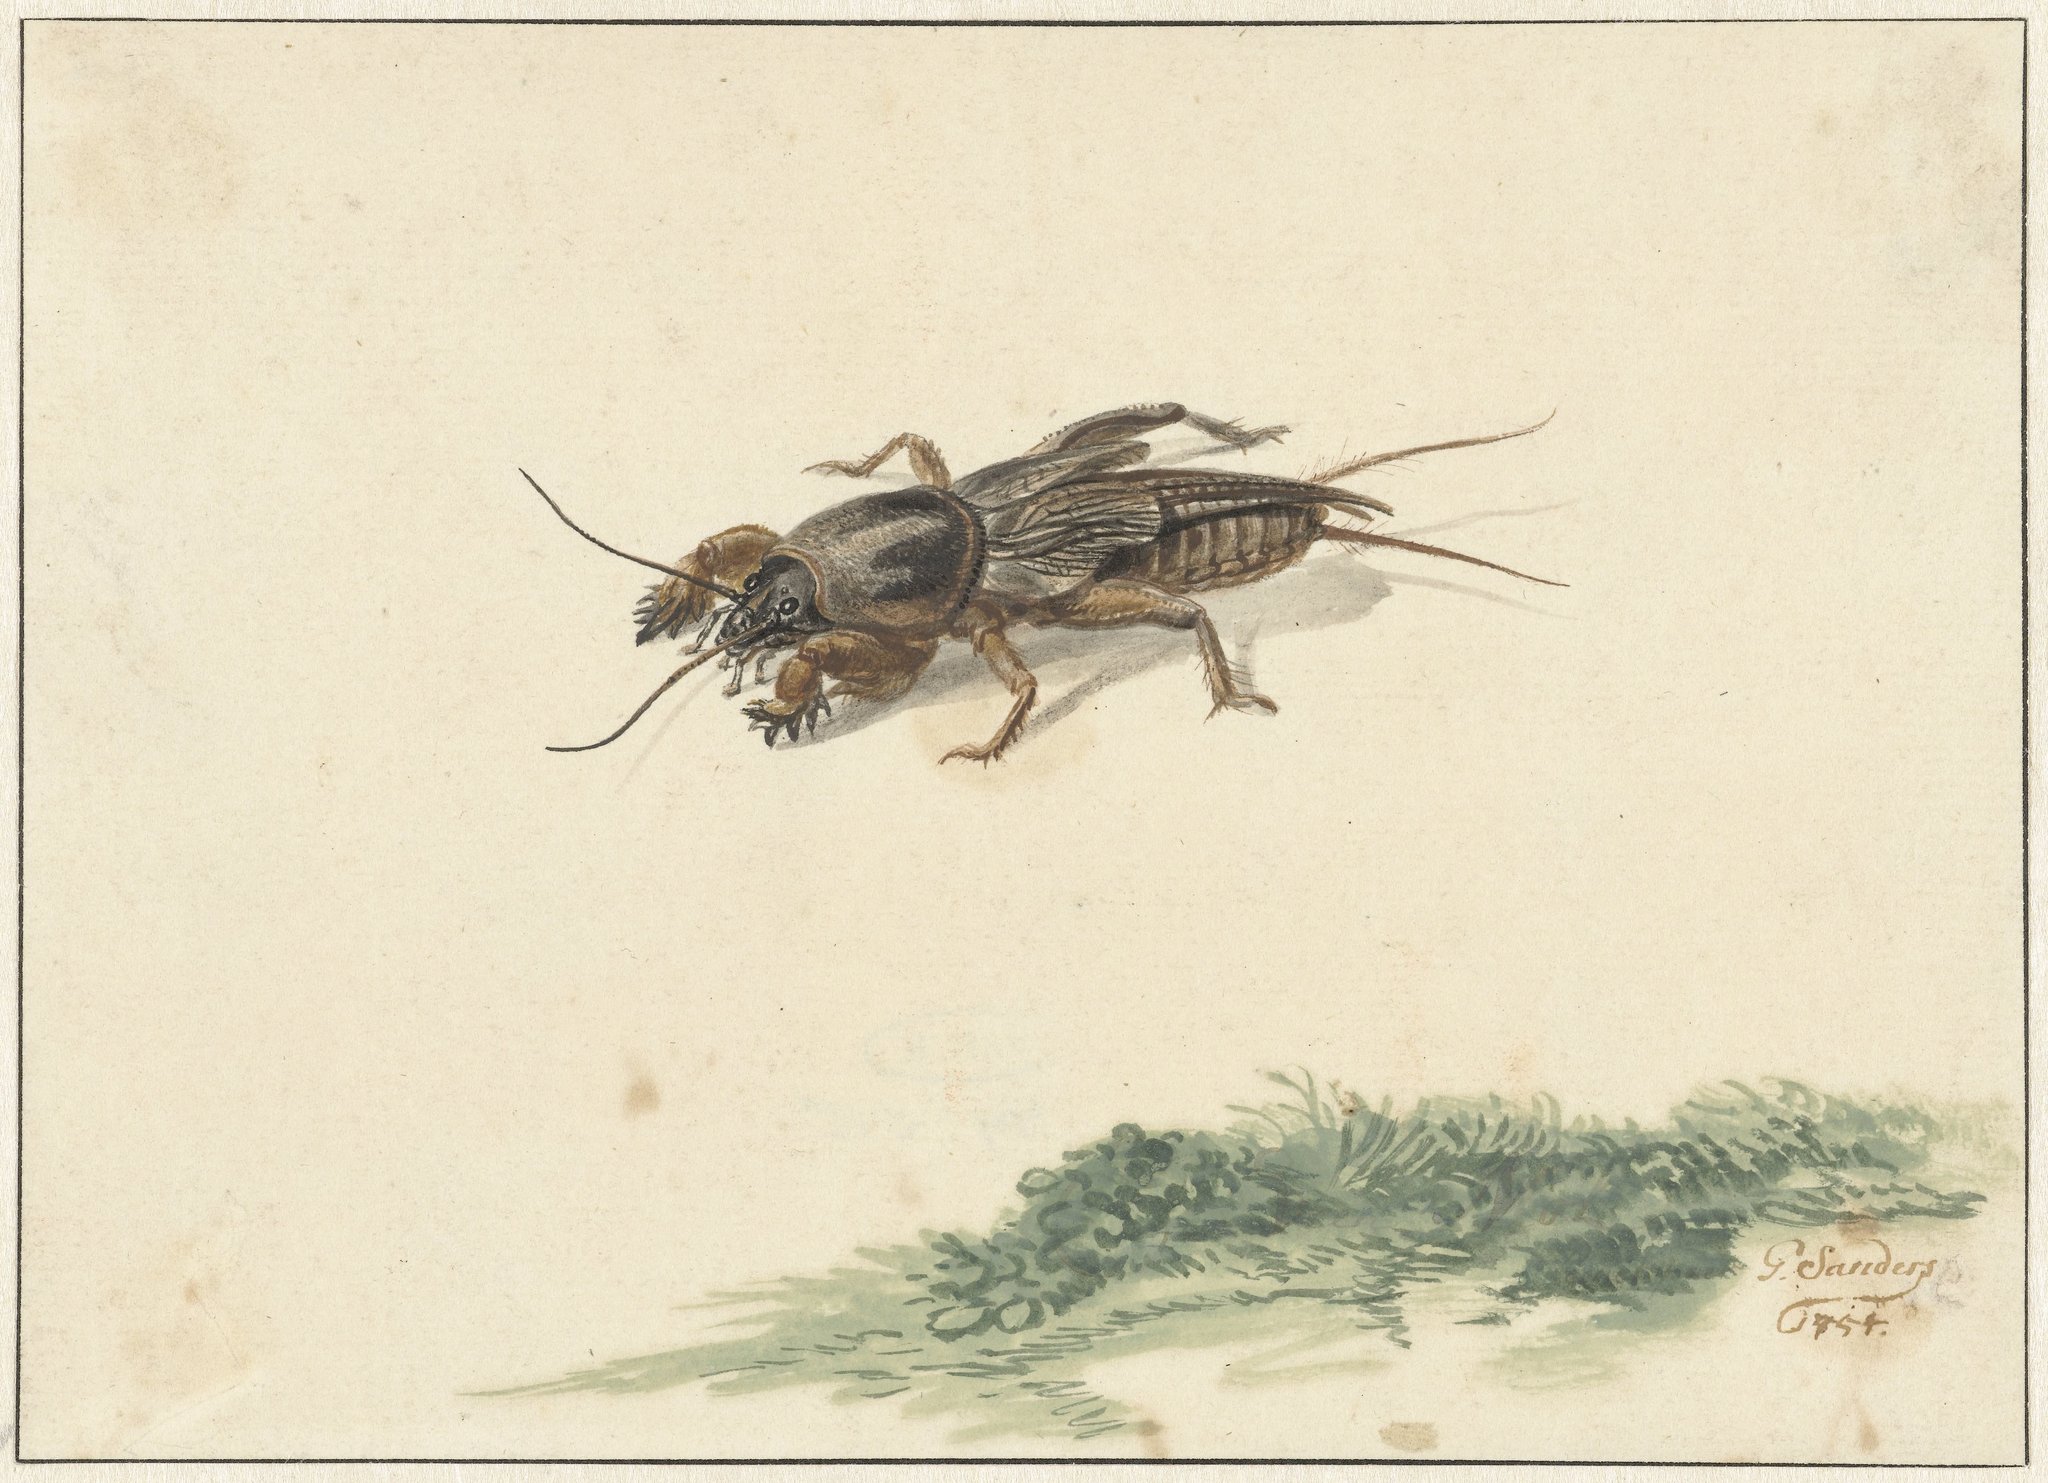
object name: drawing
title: Insect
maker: gerard sanders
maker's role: draughtsman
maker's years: 1702-1767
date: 1754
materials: ink, paper, watercolor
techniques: brush, pen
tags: insects